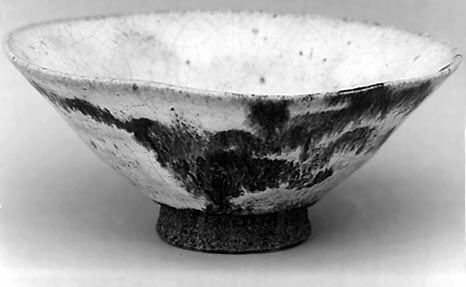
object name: bowl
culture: japanese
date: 1780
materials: glaze, pottery